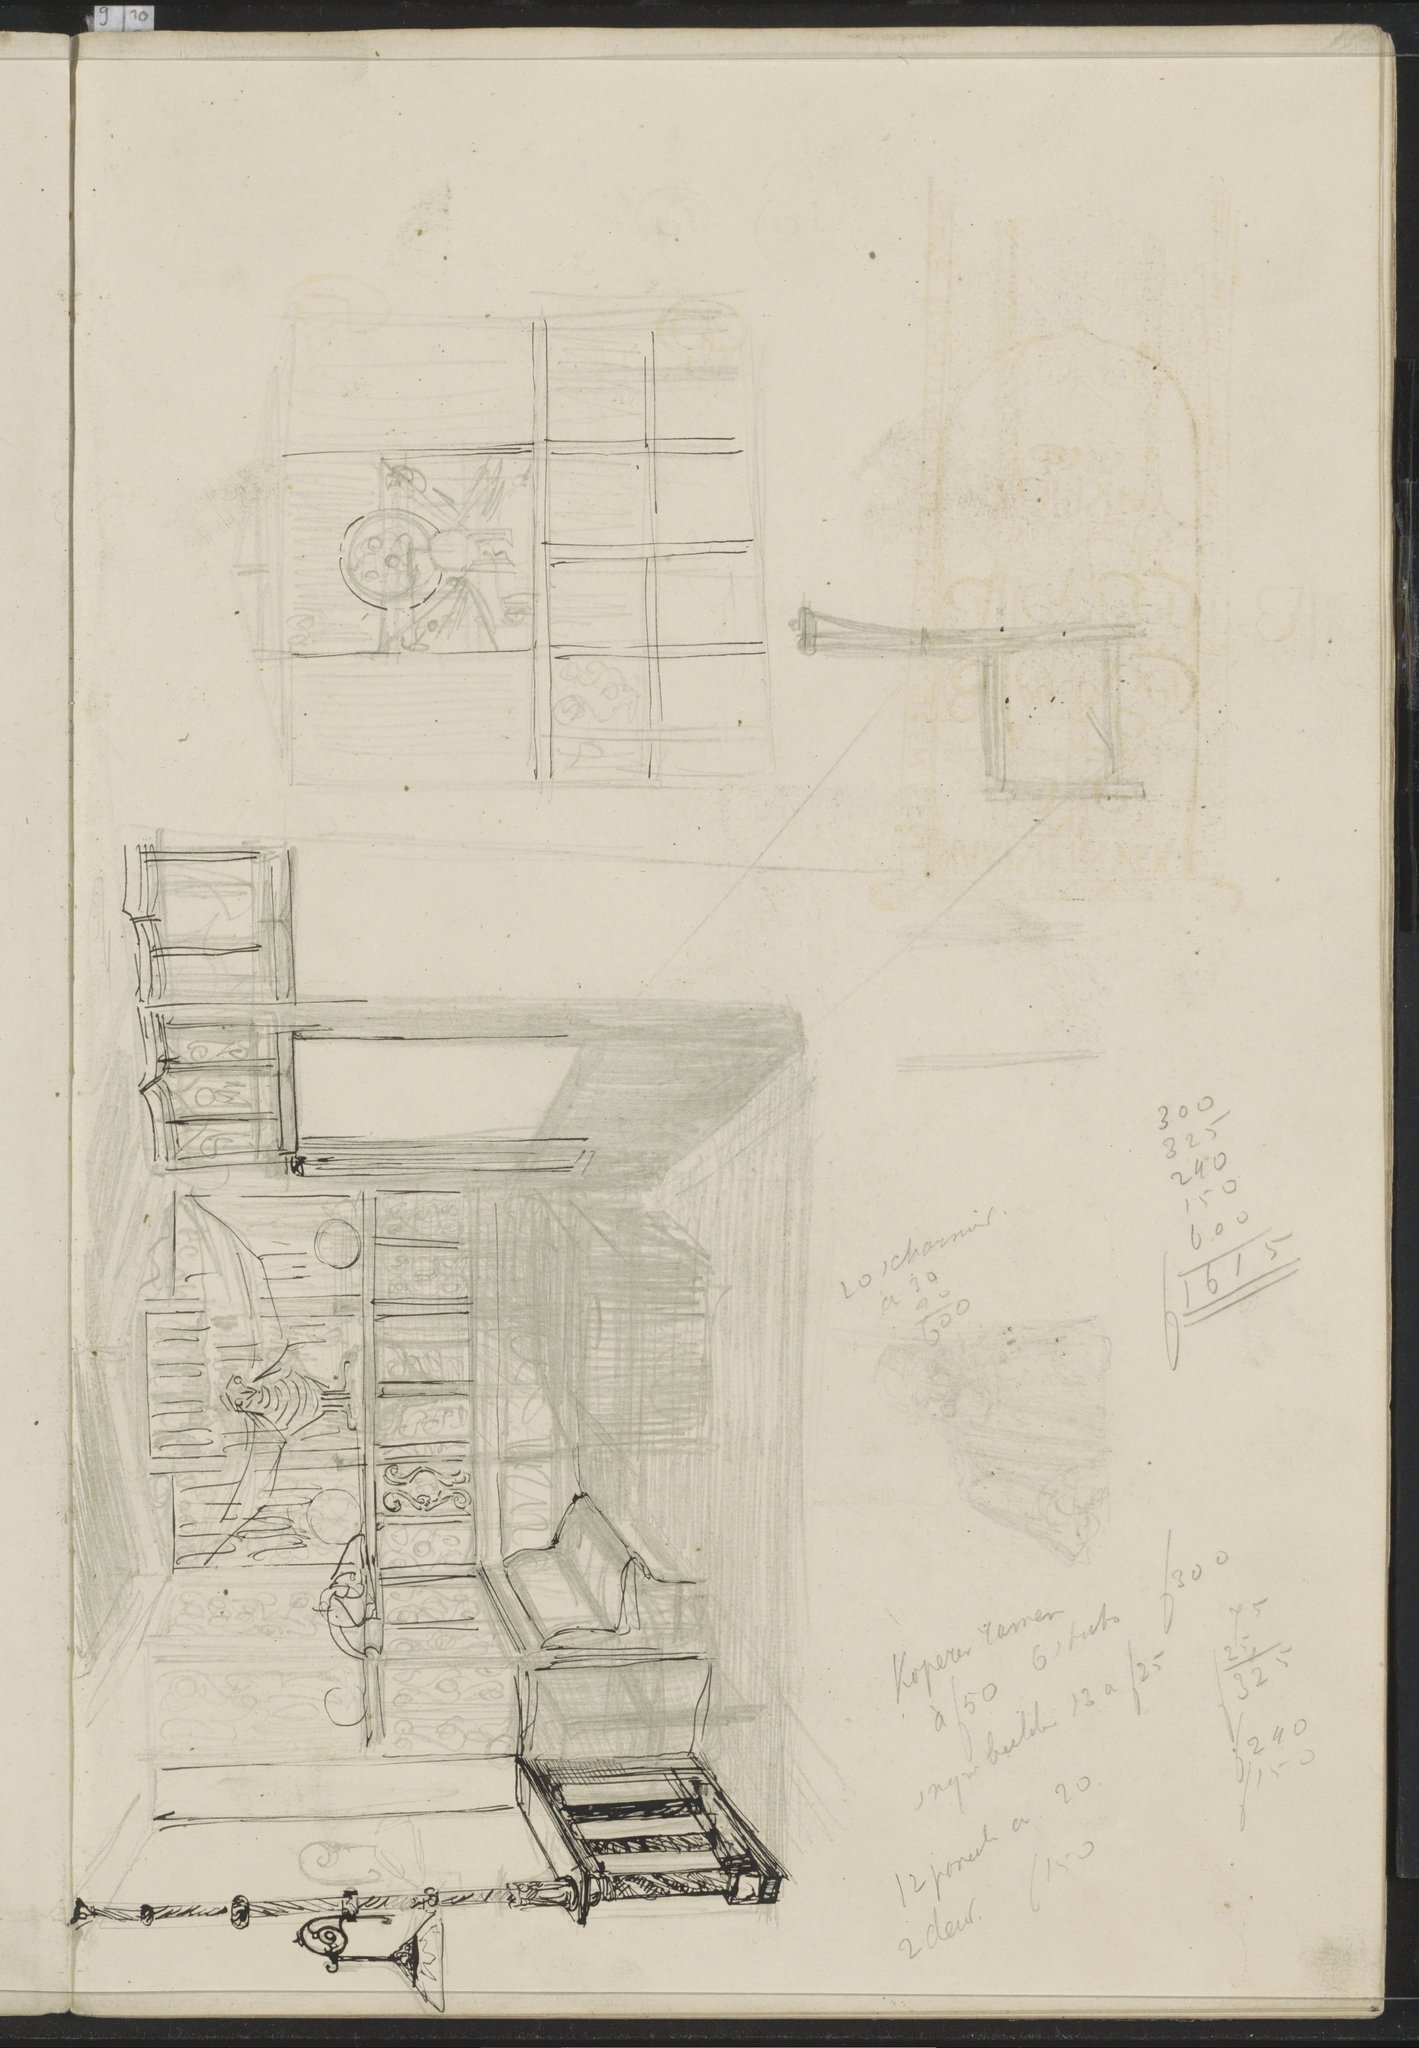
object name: sketchbook leaf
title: Interieur met wandbetimmering, een bank en schouw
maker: carel adolph lion cachet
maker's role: draughtsman, print maker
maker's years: 1864-1945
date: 1903-1904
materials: ink, paper, pencil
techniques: pen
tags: panelling, interior of the house, chair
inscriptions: annotation: ‘[...]’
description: Tevens een studie van wandbetimmering en een stoel. Blad 6 recto uit een schetsboek met 17 bladen.